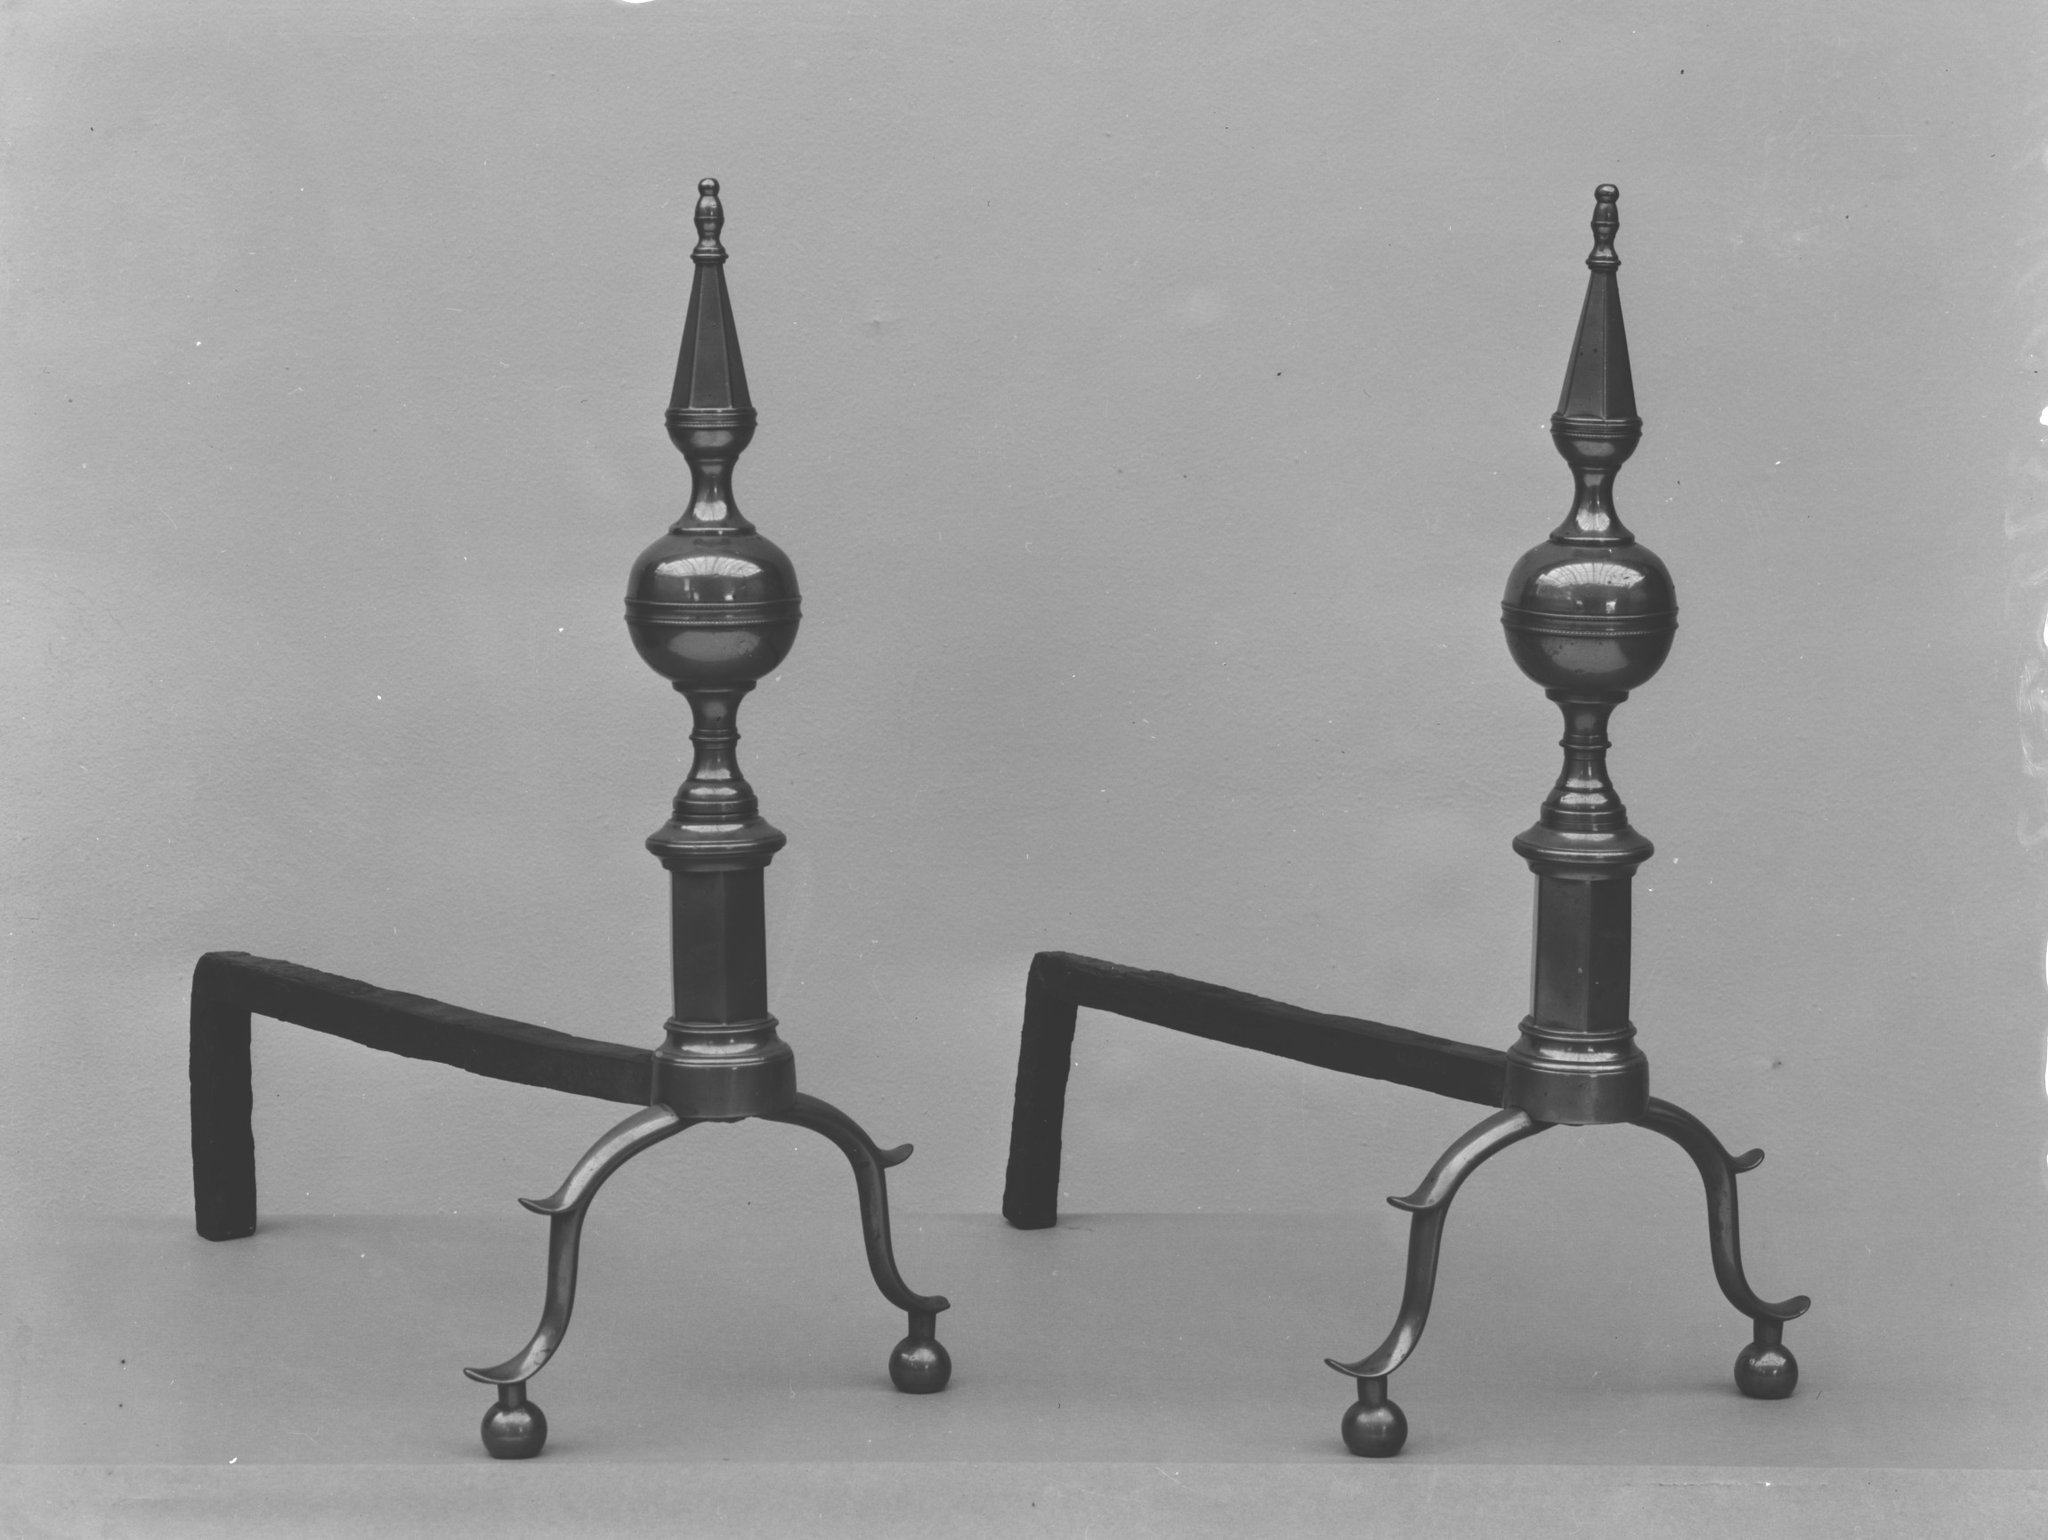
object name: andiron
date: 1770-1830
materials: brass